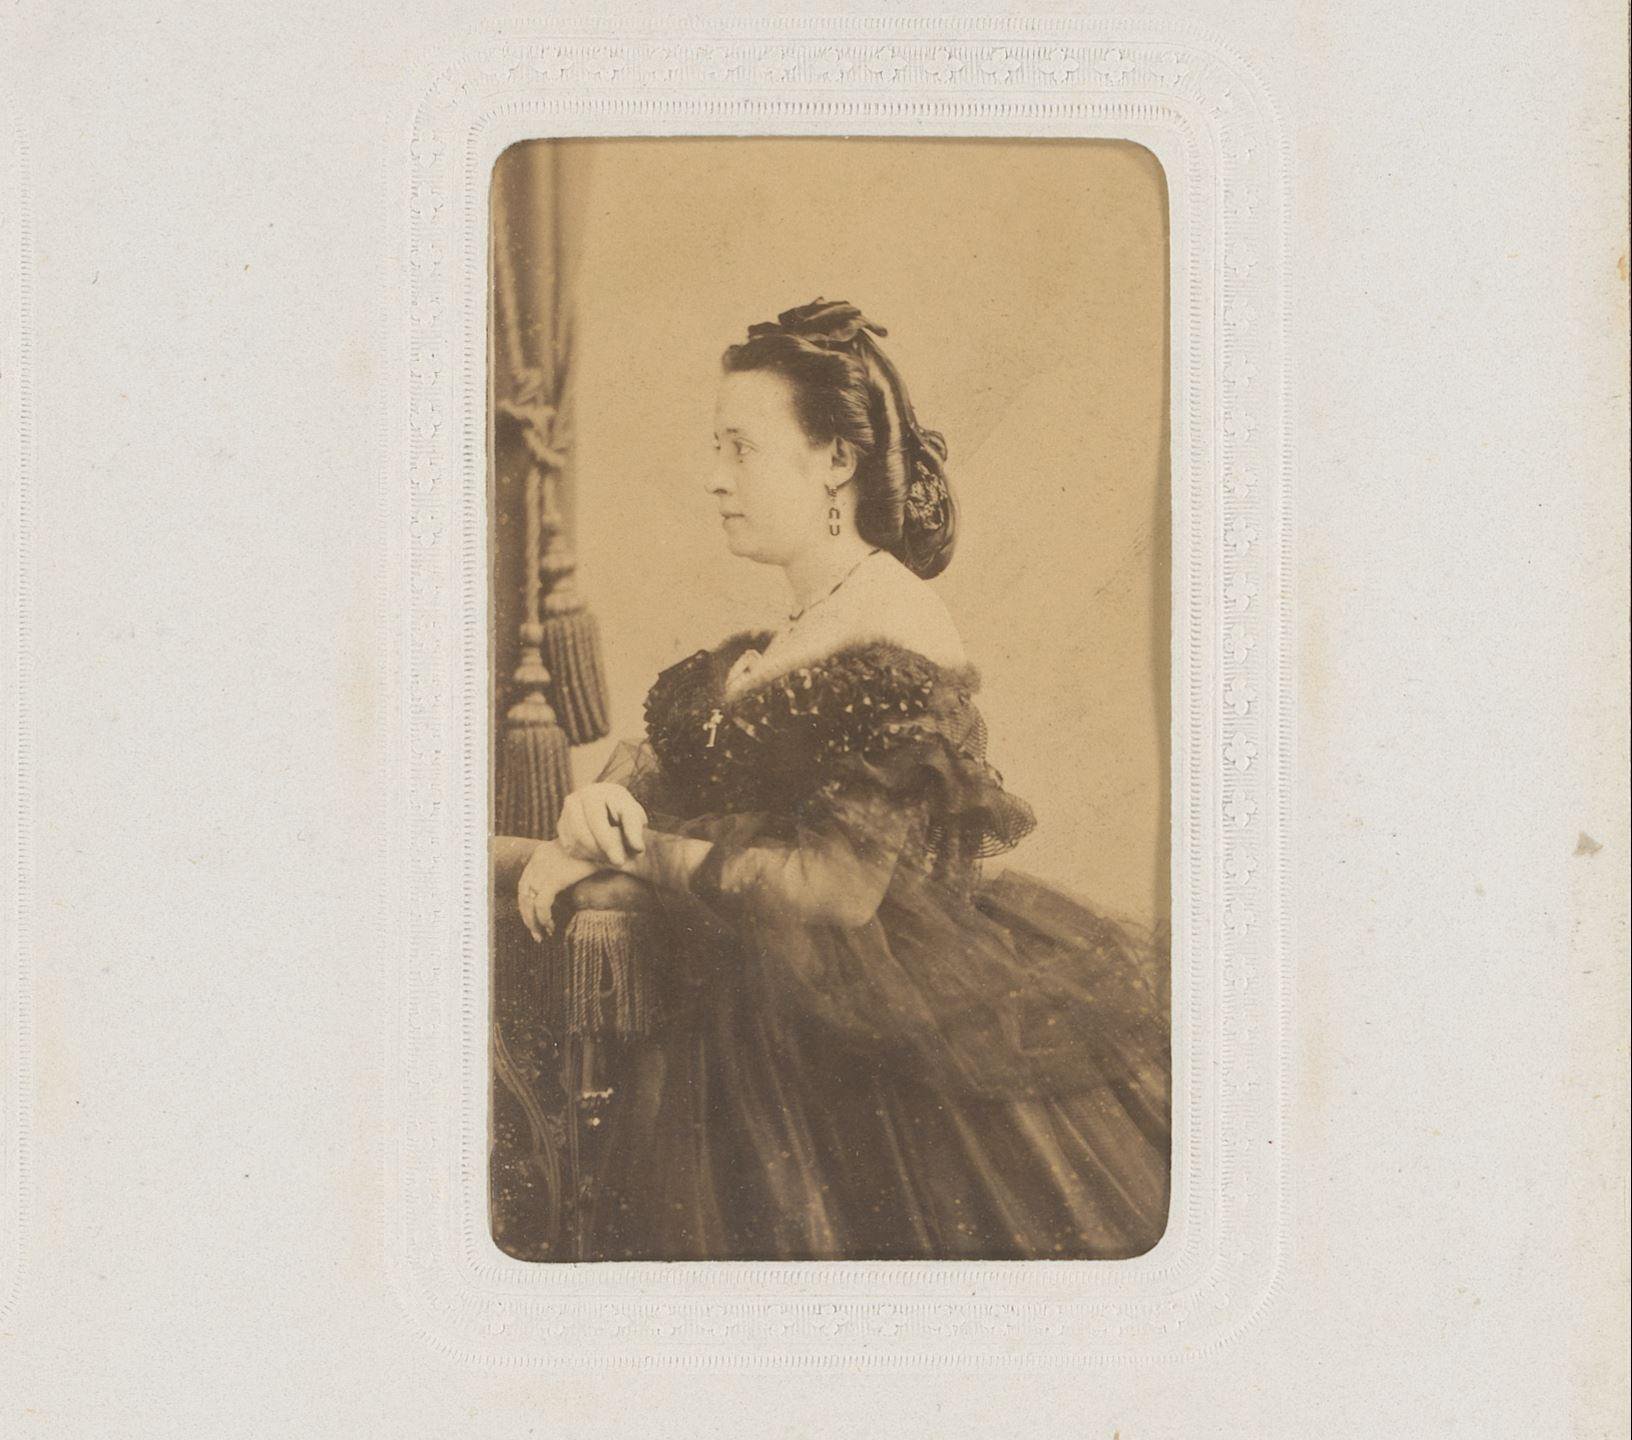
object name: carte de visite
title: Portret van een vrouw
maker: j.b. fernandez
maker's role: fotograaf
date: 1860-1890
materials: cardboard, photographic support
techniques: albumen print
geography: havana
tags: historical persons - bb - woman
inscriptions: inscription: ‘Fernandez/ Fotógrafo/ Con Rl Privilegio/ O'Reilly 66/ Habana’